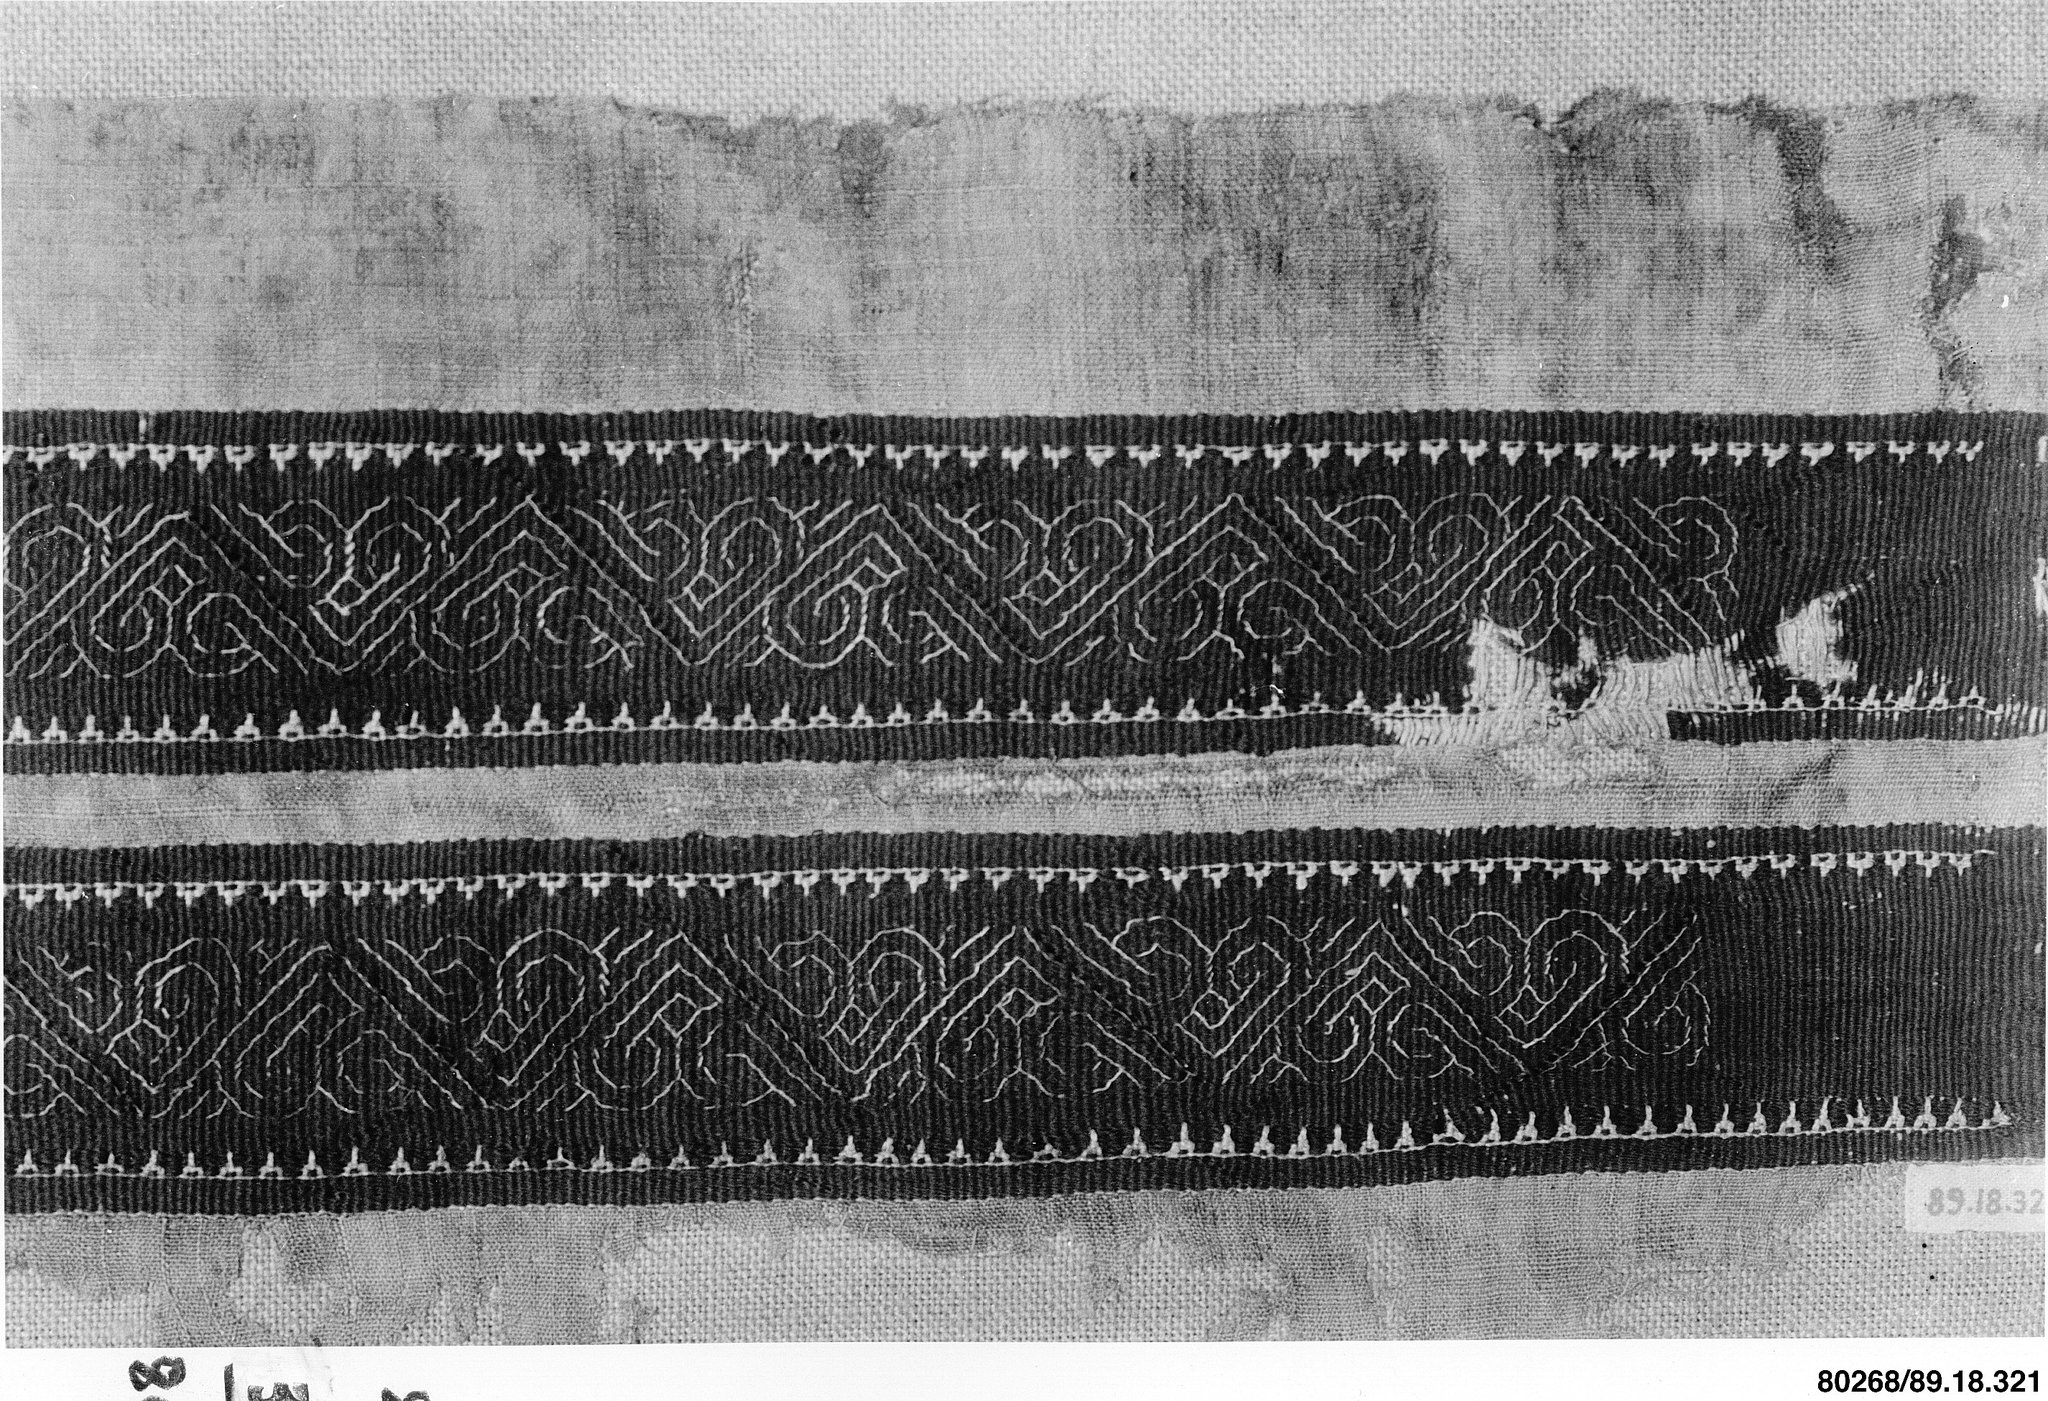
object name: textile fragment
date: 201-400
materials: linen, wool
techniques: weave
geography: egypt